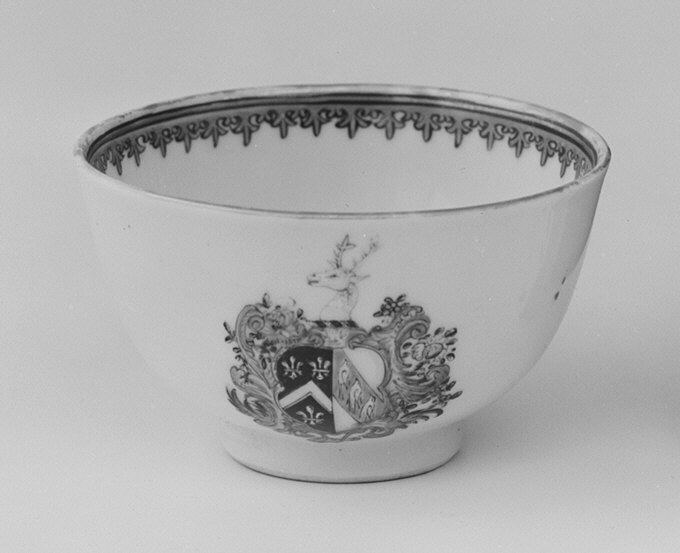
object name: teacup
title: Tea cup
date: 1760-1770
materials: hard paste porcelain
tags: coat of arms